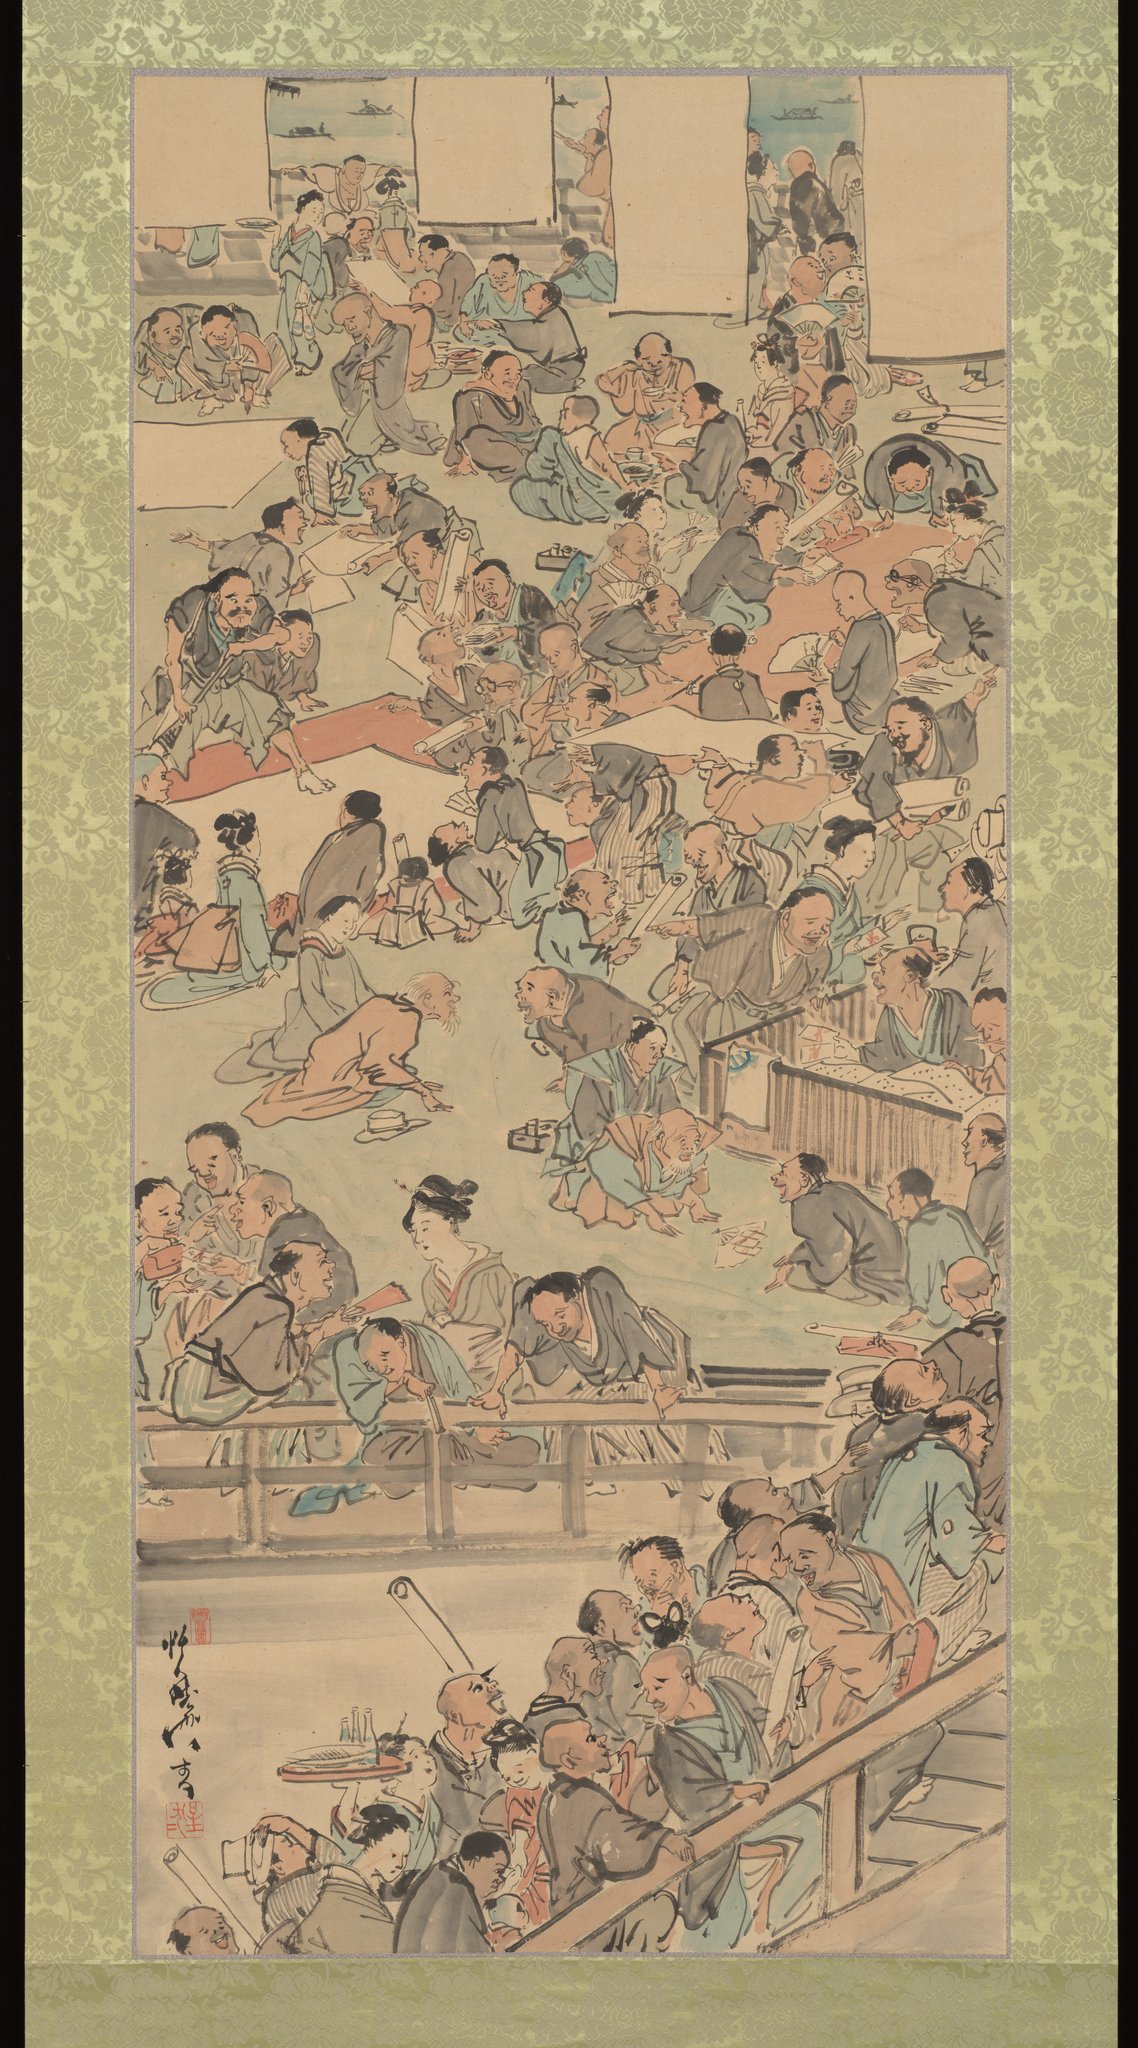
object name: hanging scroll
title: Painting and Calligraphy Gathering at the Nakamurarō in Ryōgoku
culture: japanese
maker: kawanabe kyōsai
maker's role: artist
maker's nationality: japanese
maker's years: 1831-1889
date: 1876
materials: ink, paper